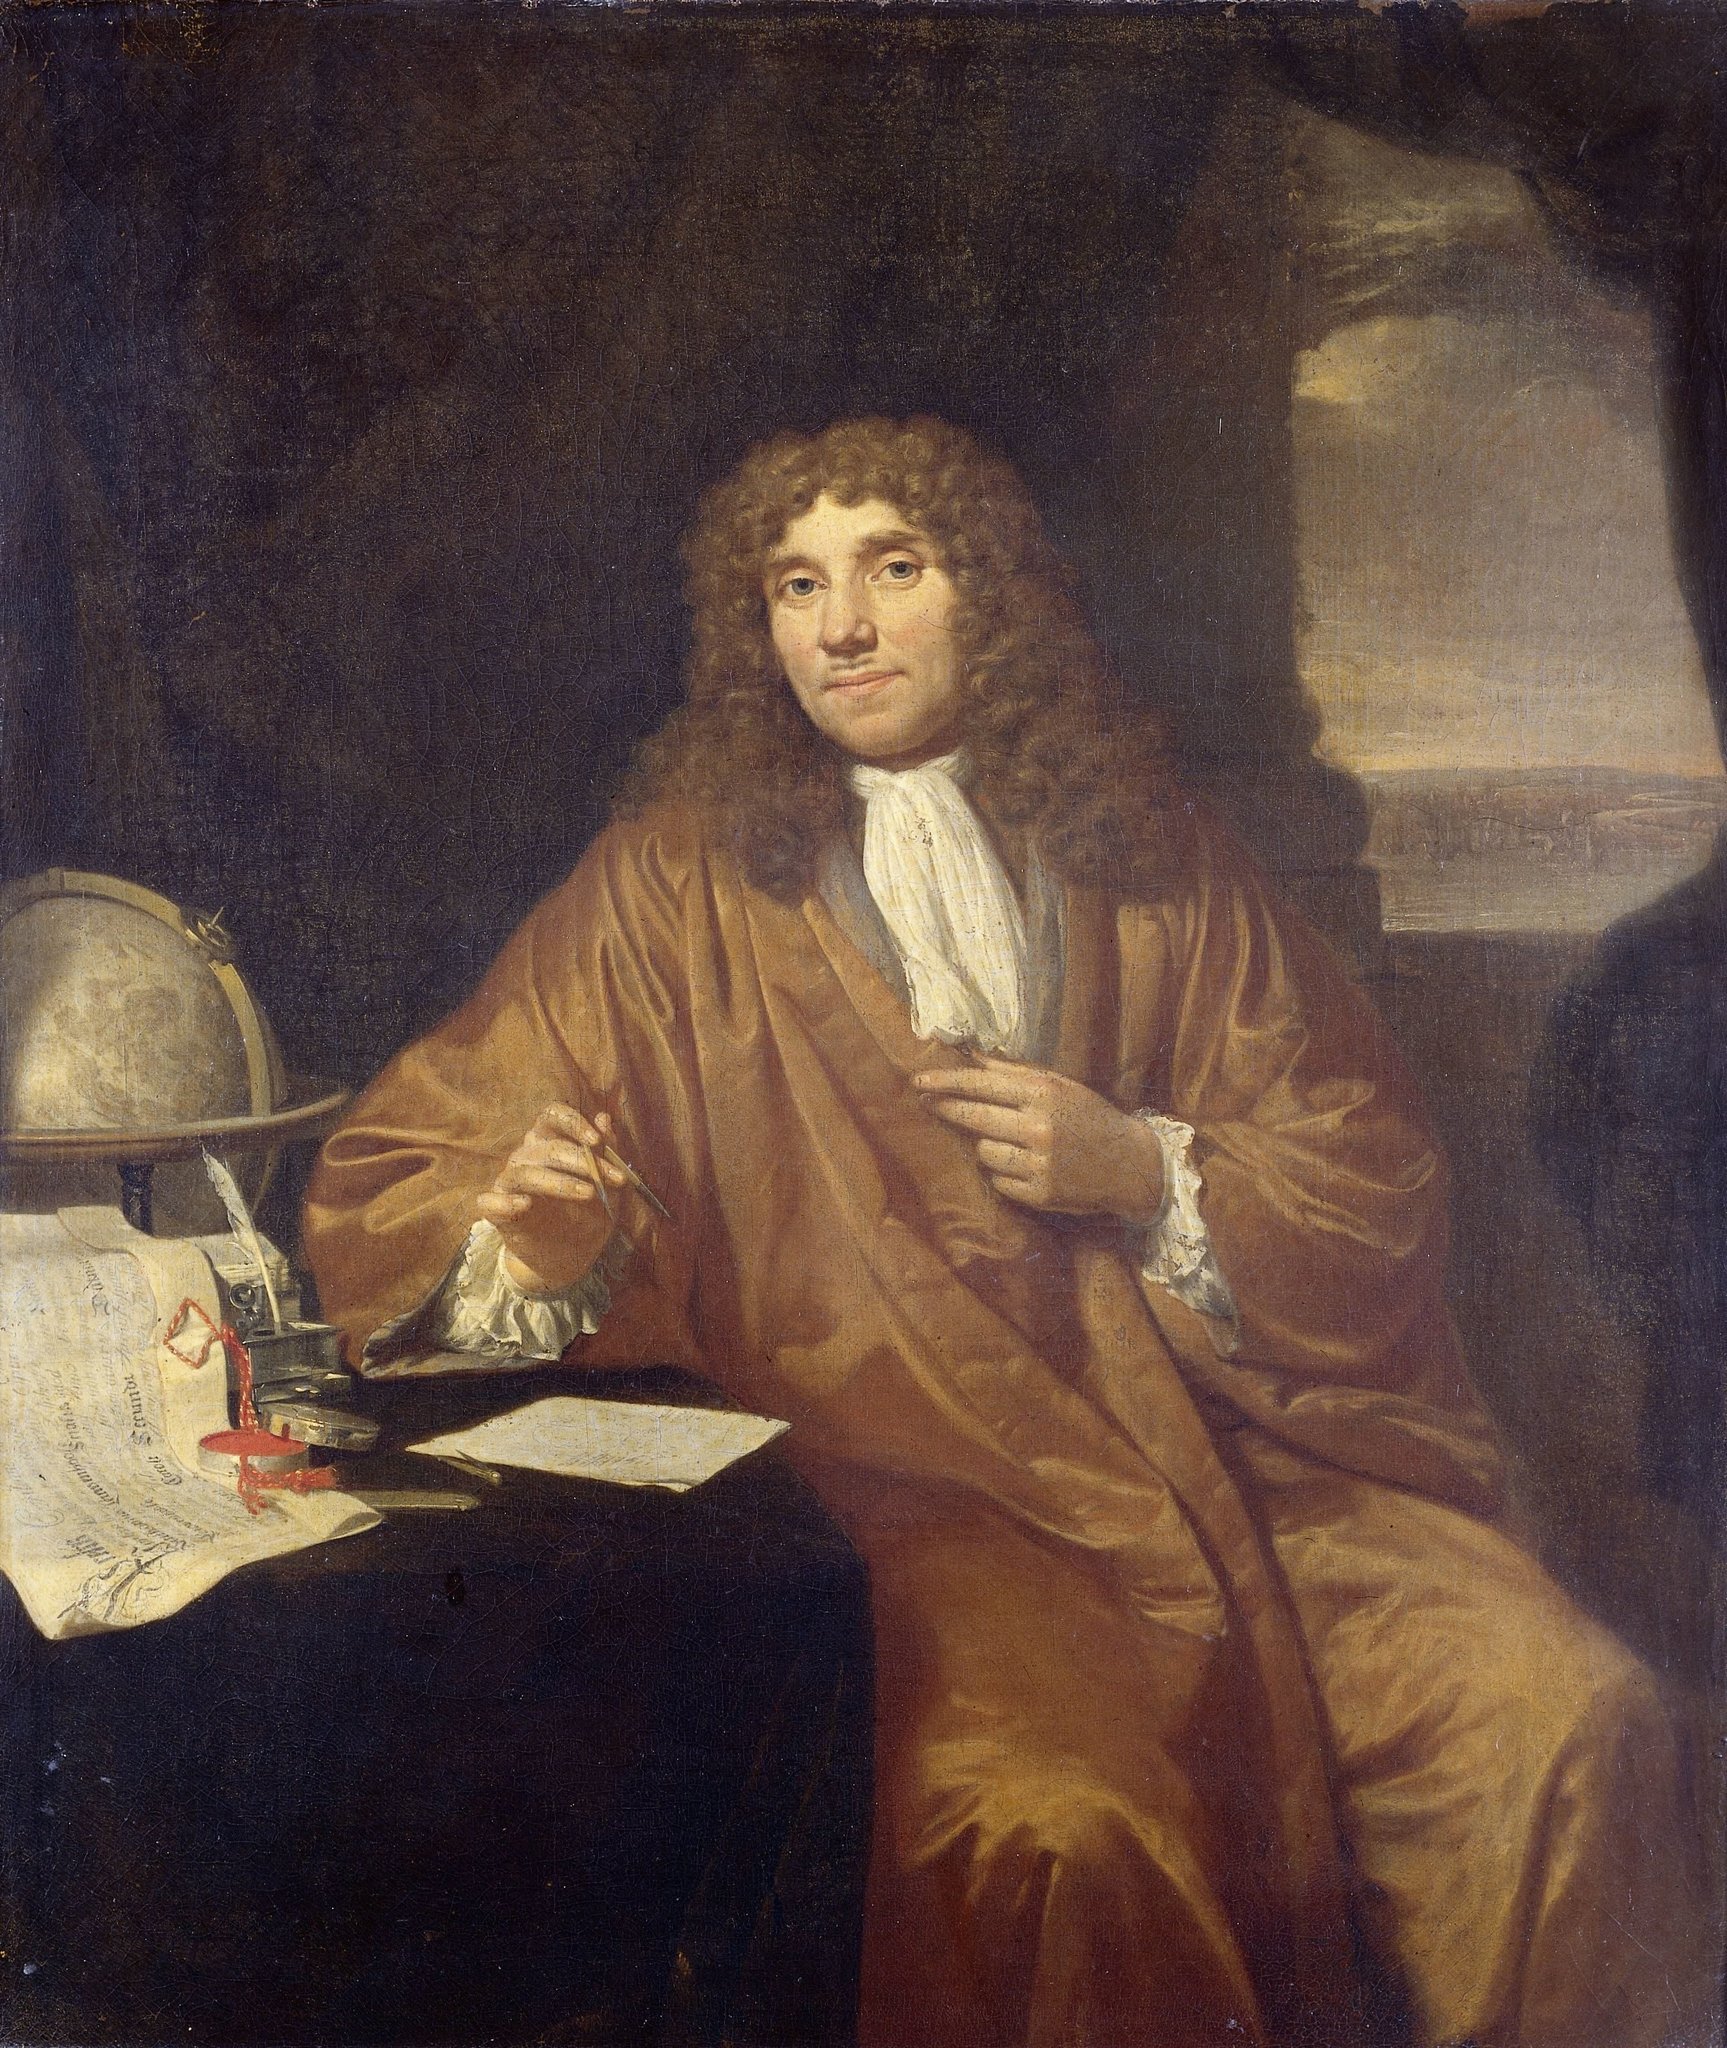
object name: painting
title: Portrait of Anthonie van Leeuwenhoek, Natural Philosopher and Zoologist in Delft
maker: jan verkolje (i)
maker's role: draughtsman, painter, print maker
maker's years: 1650-1693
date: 1680-1686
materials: canvas, oil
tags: physicist, anthony van leeuwenhoek, scholar in his study, historical persons, delft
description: Portret van Anthonie van Leeuwenhoek (1632-1723), natuurkundige te Delft. Kniestuk, zittend aan een schrijftafel waarop een oorkonde ligt van zijn benoeming tot lid van de Royal Society te Londen door Karel II. Verder ook een globe en een inktstel; hij houdt een passer in de hand.